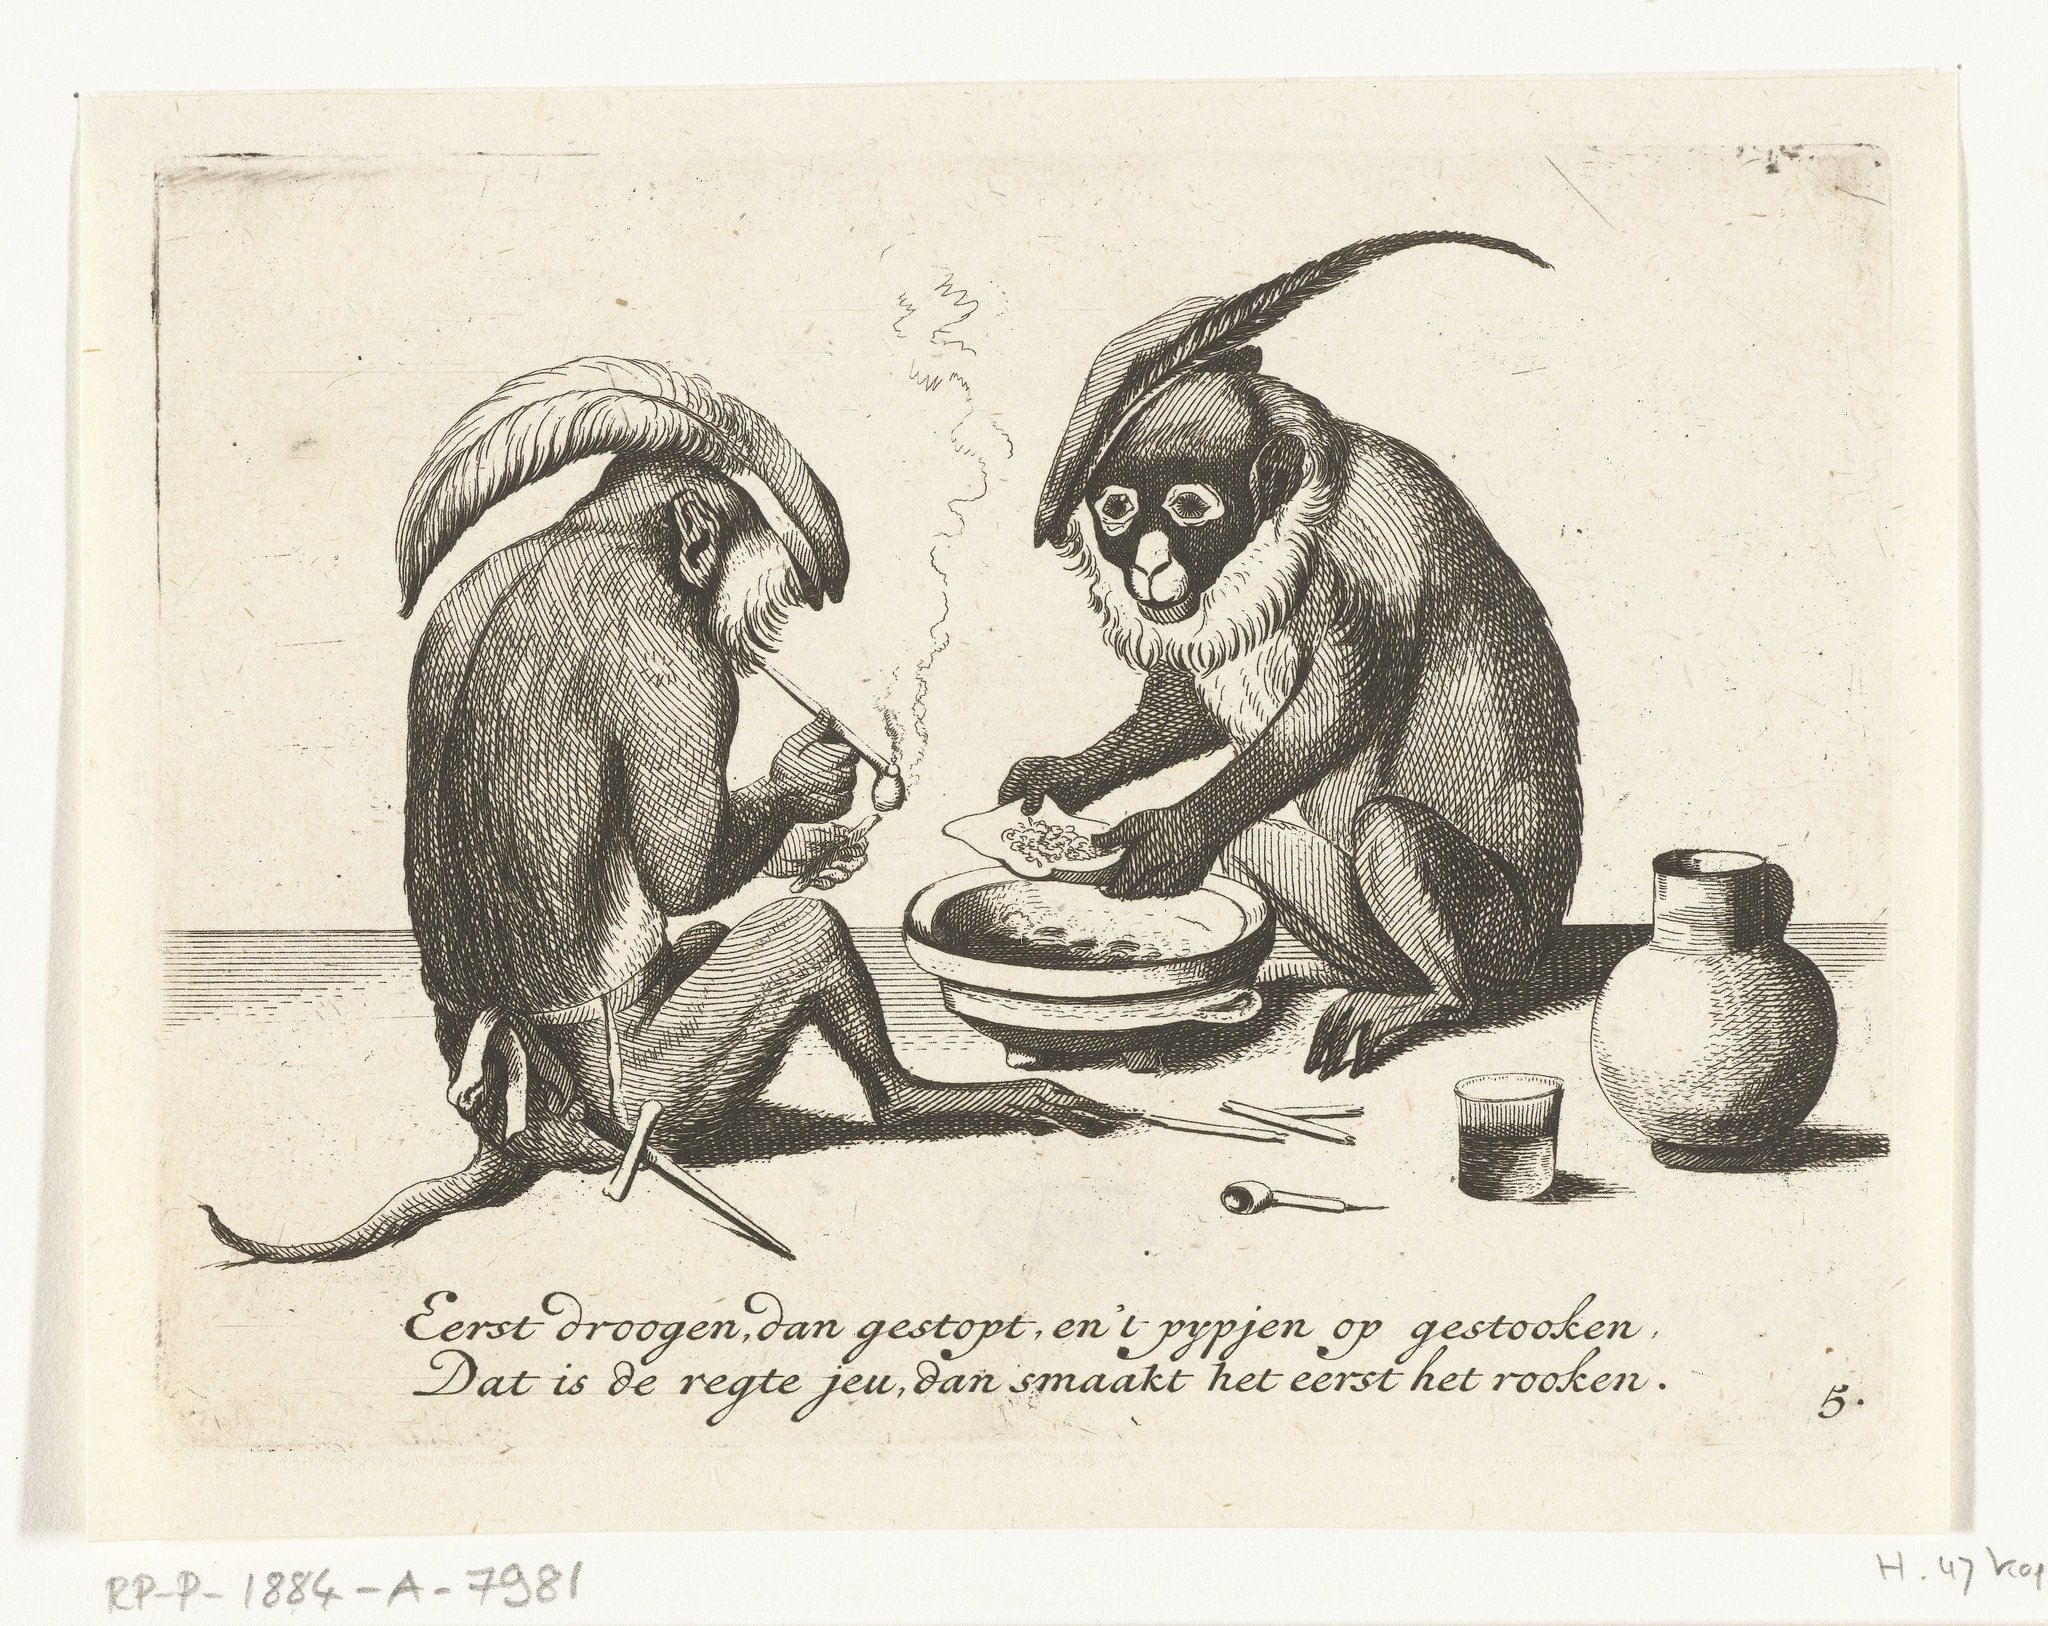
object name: print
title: Verschillende bedrijven uit het menselijke leven door apen voorgesteld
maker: Anonymous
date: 1635-1724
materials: paper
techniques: engraving, etching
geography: low countries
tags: animals acting as human beings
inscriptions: collector's mark: Lugt 2228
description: Twee apen zitten op de grond, de ene blaast zijn pijpje aan. De andere aap zit tabak te drogen boven een vuurpot. Prent uit een serie van zes prenten en een titelprent waarin verschillende menselijke bezigheden door apen voorgesteld worden. Kopieën naar prenten van Quirin Boel, met een toegevoegd vers in het Nederlands onder elke voorstelling.